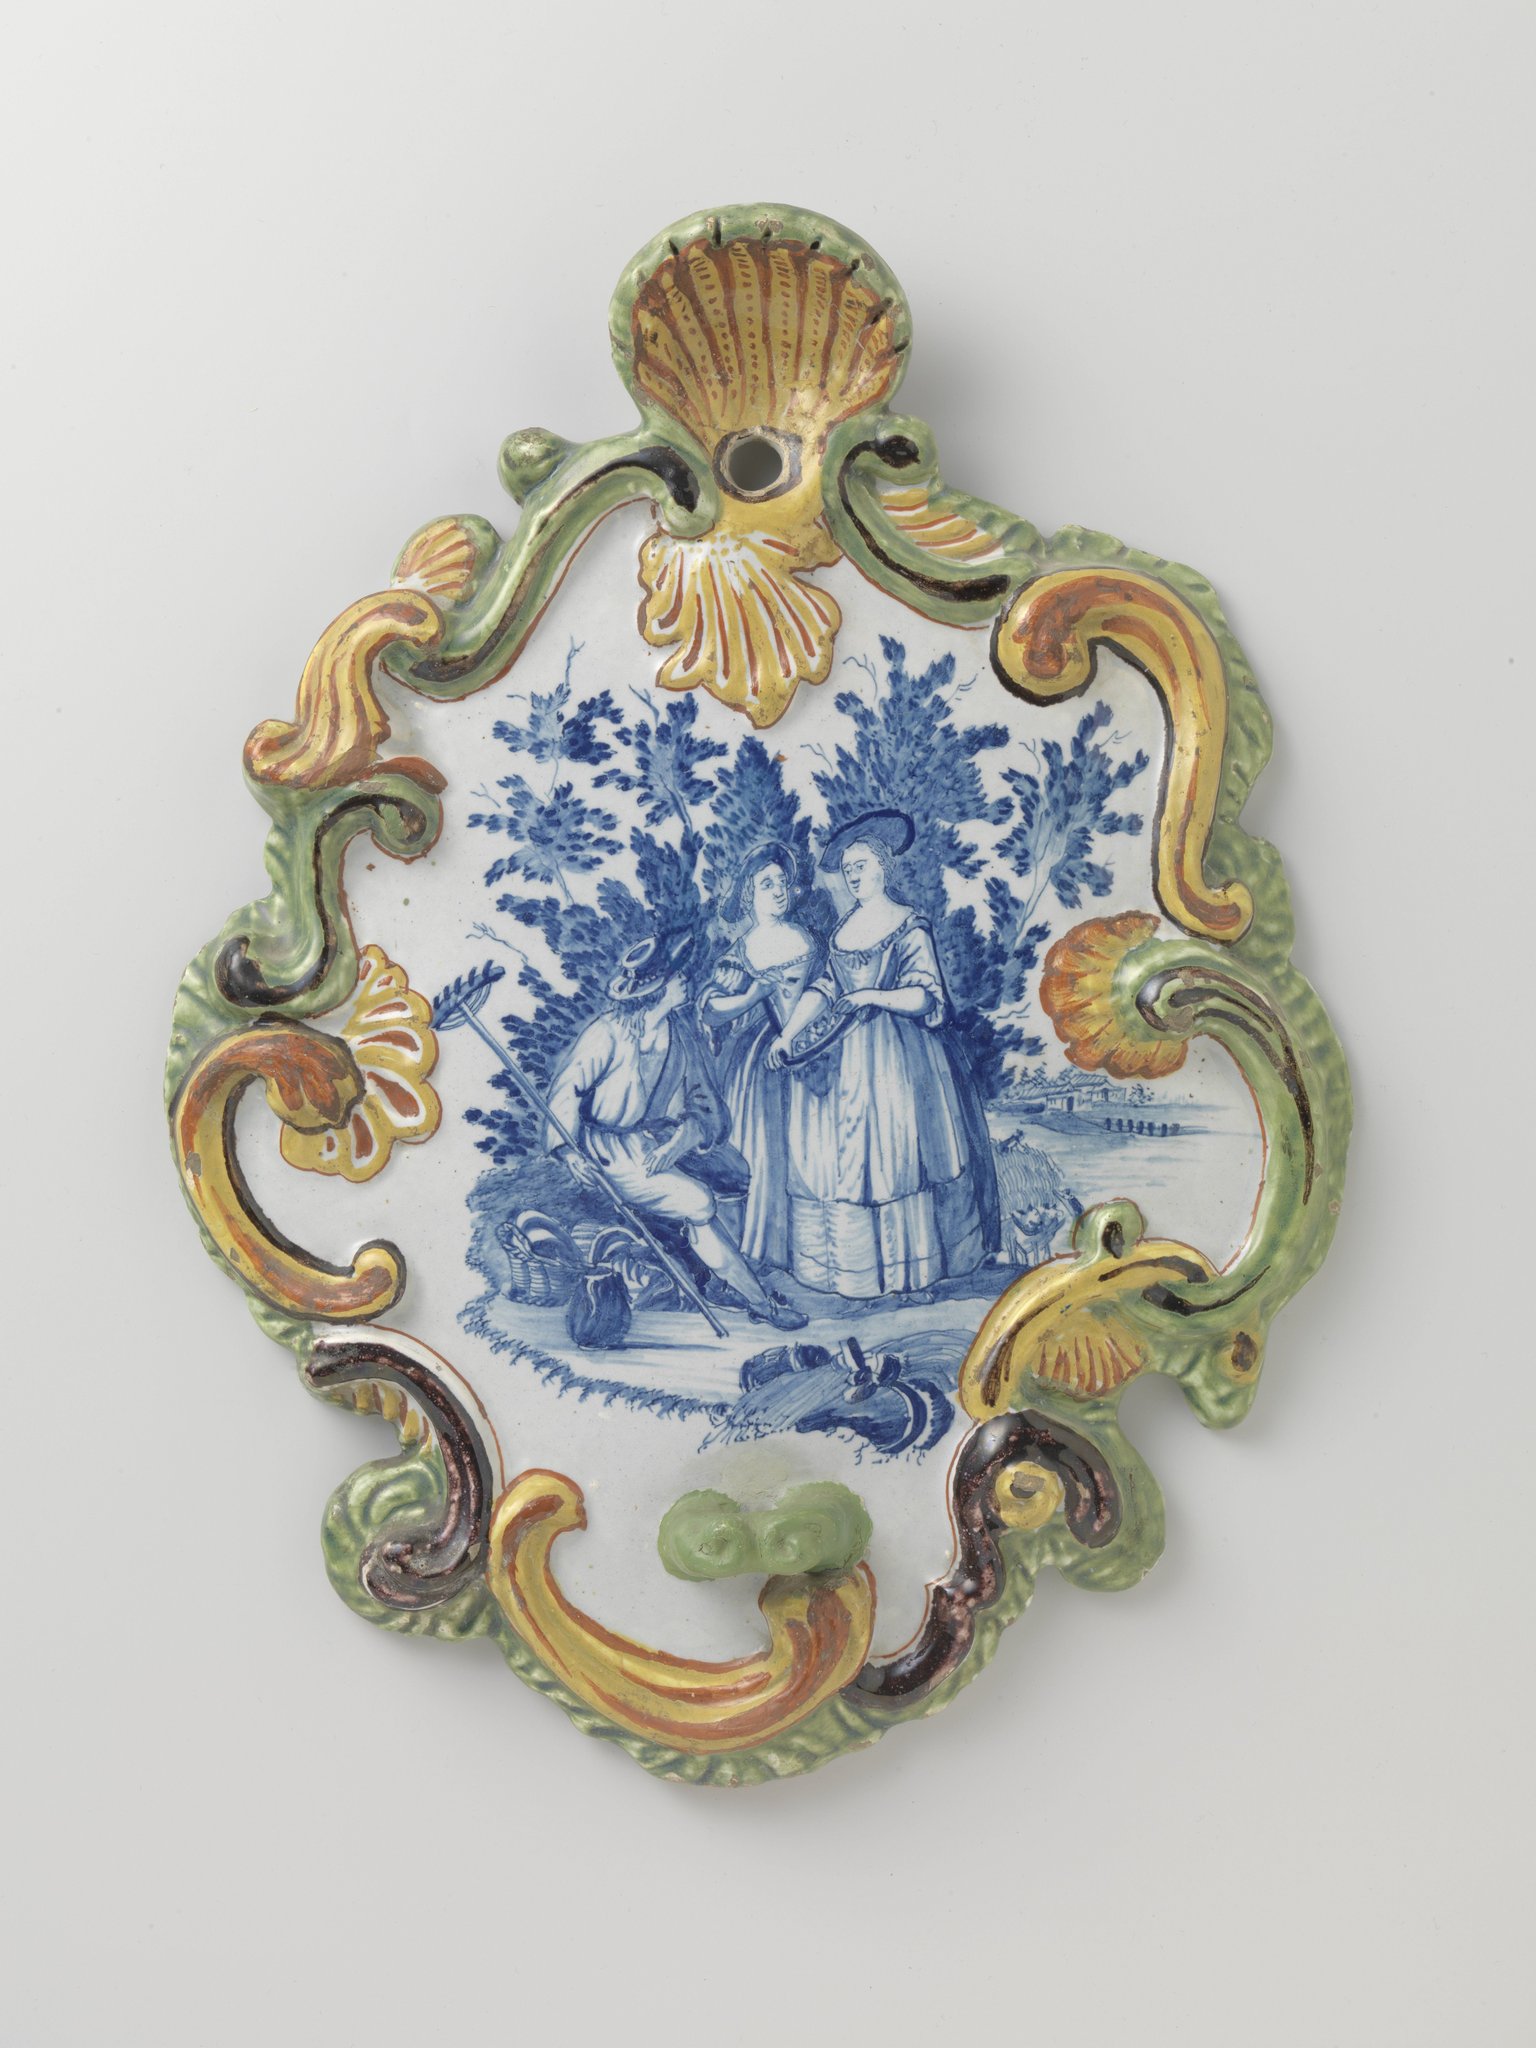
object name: vessel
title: Applique, veelkleurig beschilderd met een landschap met figuren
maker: Anonymous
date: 1760-1780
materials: earthenware, glaze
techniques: painted, polychromy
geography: delft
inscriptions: collector's mark: ‘collection JF Loudon’, collector's mark: ‘424’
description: Applique van veelkleurig beschilderde faïence. De lijst is voluutvormig in relief. Op de applique is een landschap geschilderd waarin een zittende man en twee staande vrouwen.